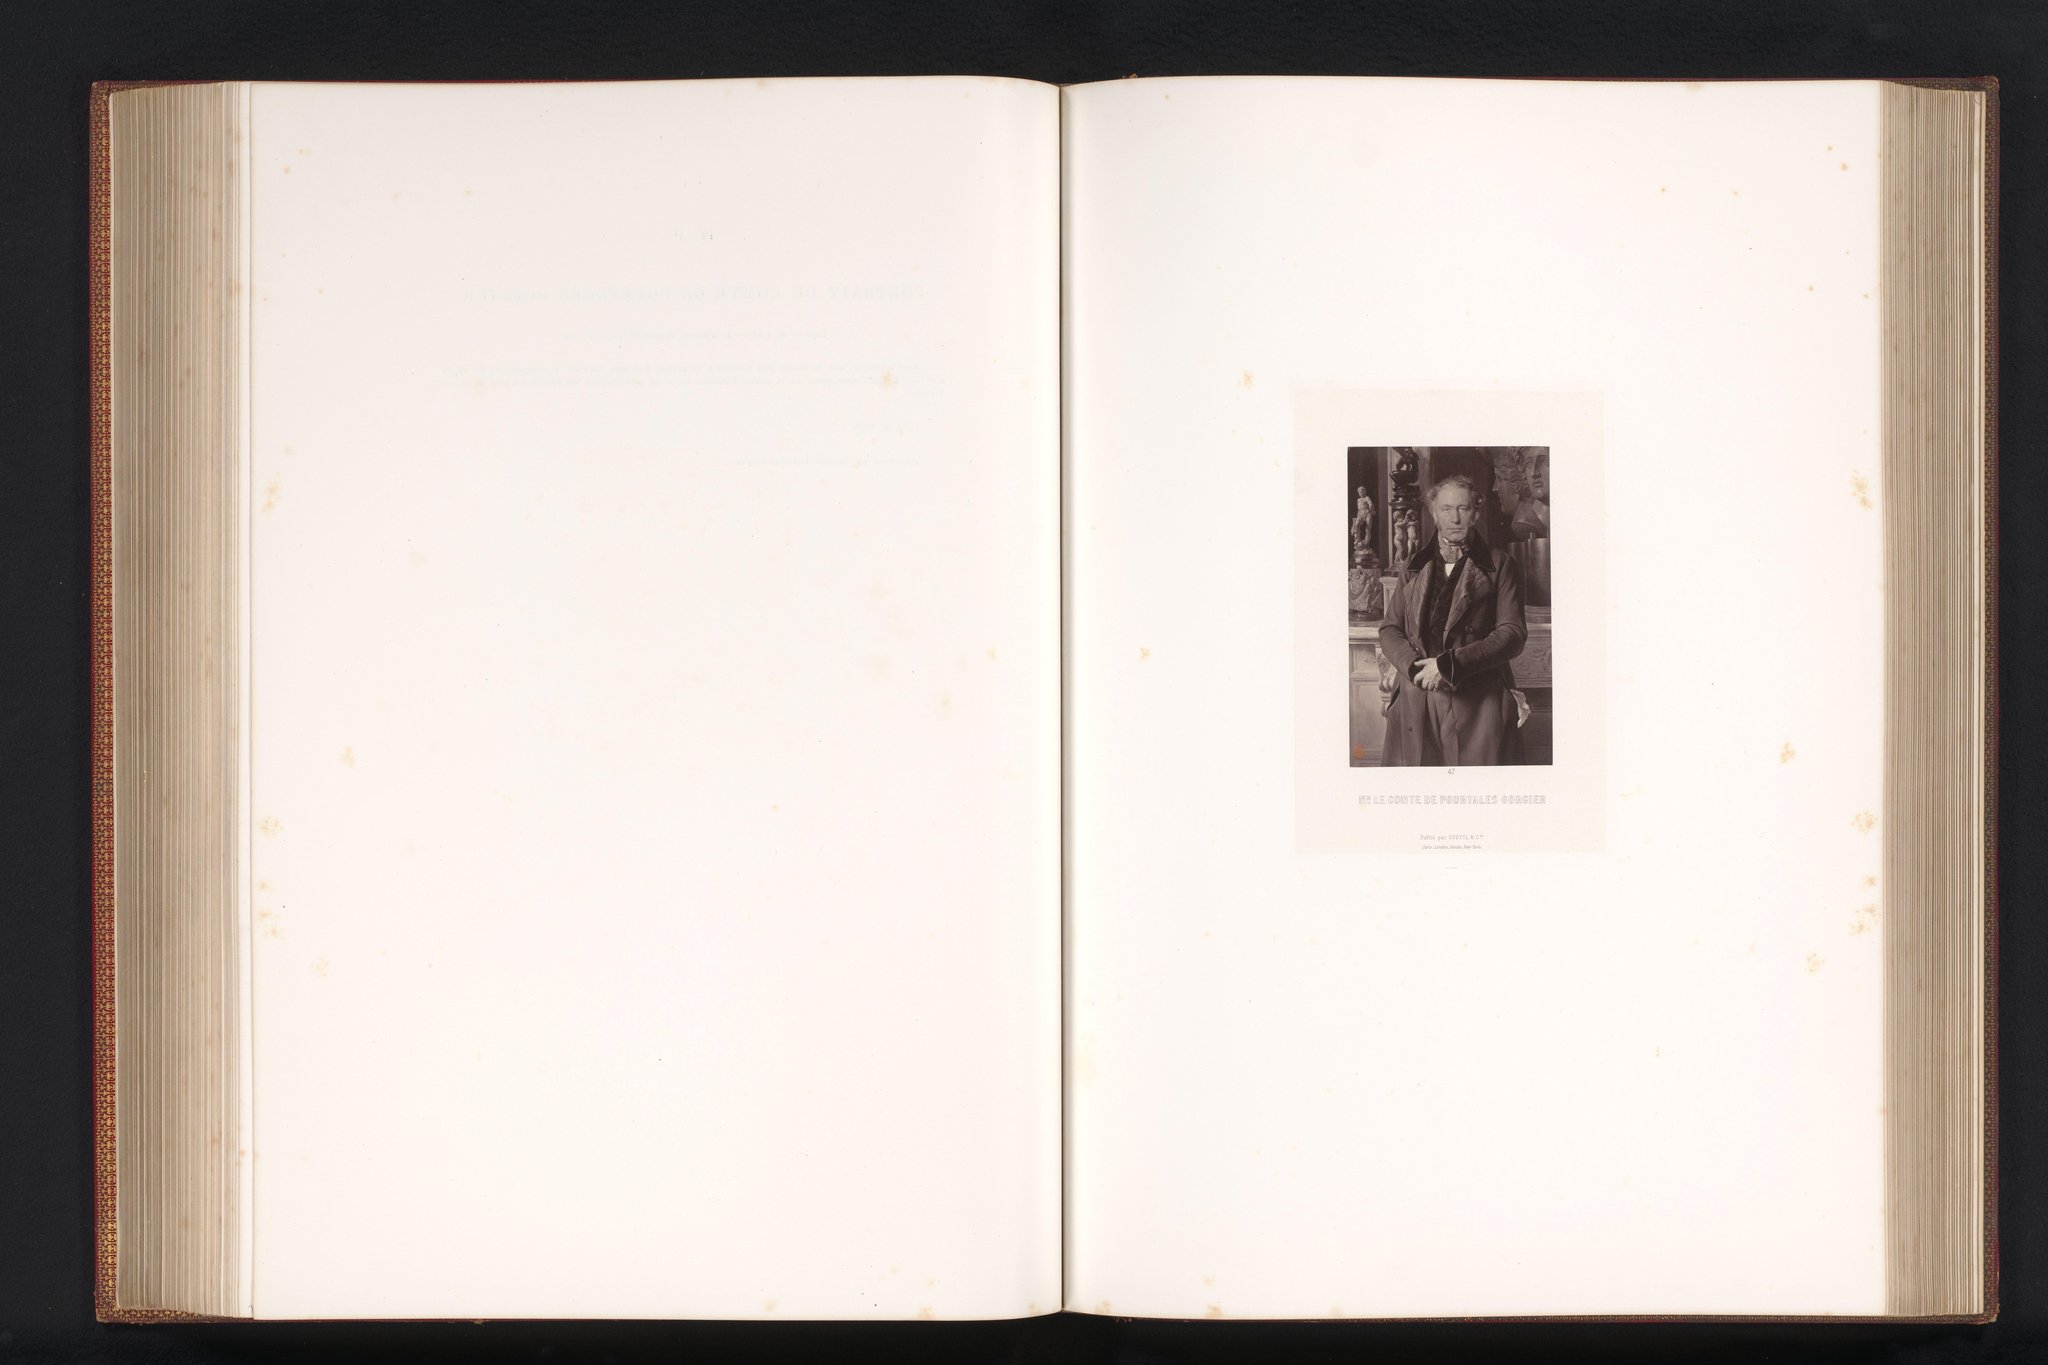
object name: photograph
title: Portrait du comte de Pourtalès-Gorgier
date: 1853-1858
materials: paper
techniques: albumen print, engraving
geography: paris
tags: earl, historical persons, art collector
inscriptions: initials: ‘GC’